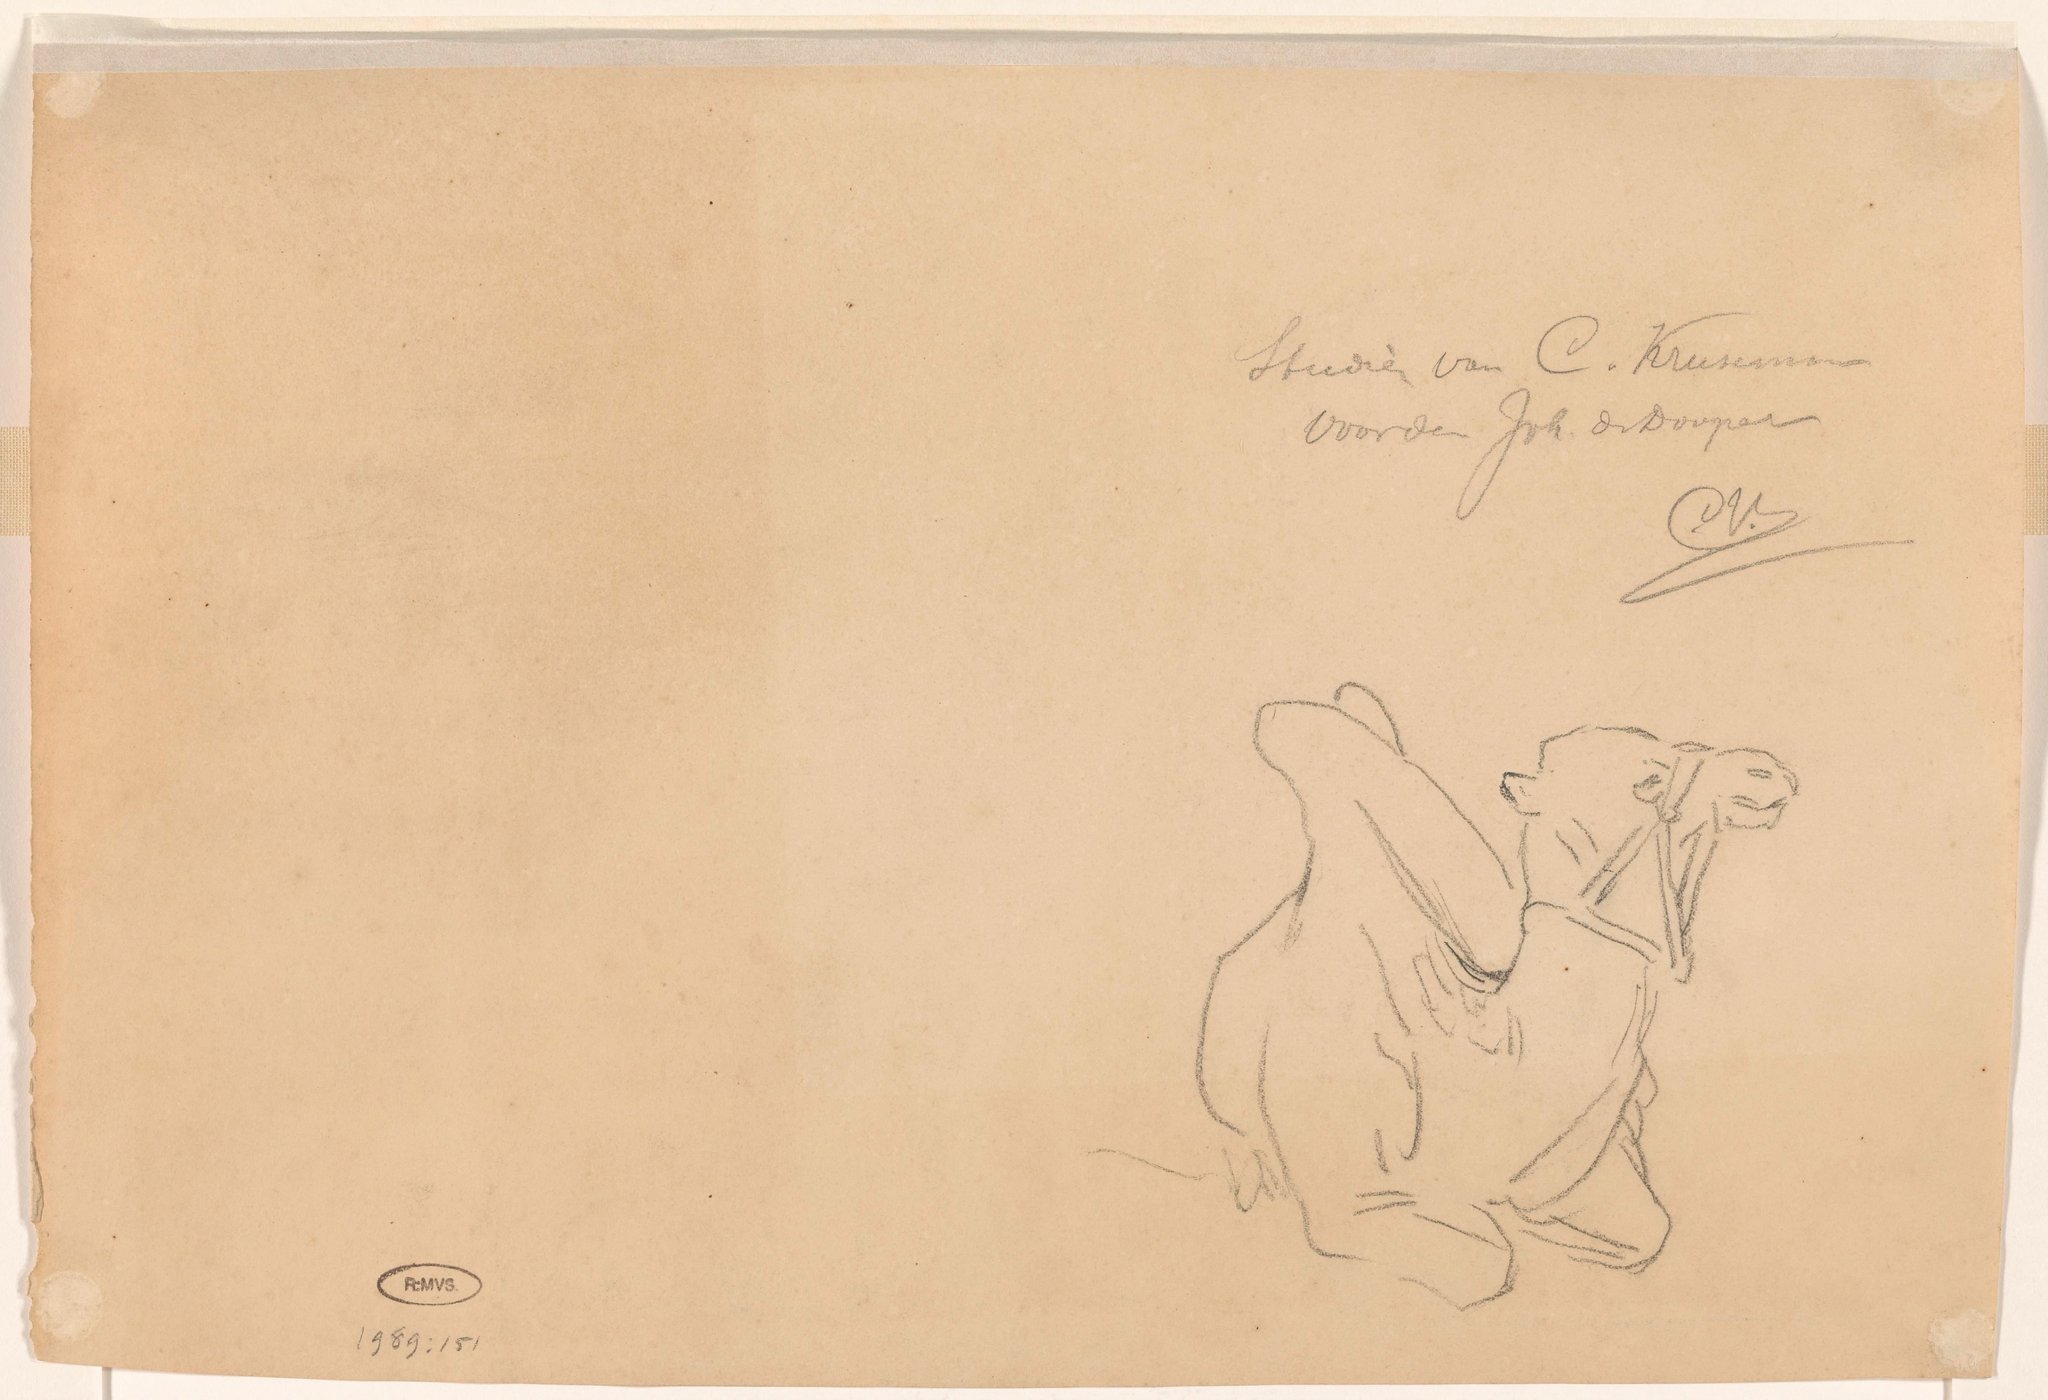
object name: drawing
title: Studie van een kameel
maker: cornelis kruseman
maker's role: draughtsman, painter, print maker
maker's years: 1797-1857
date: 1807-1857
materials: paper, pencil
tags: hoofed animals: camel